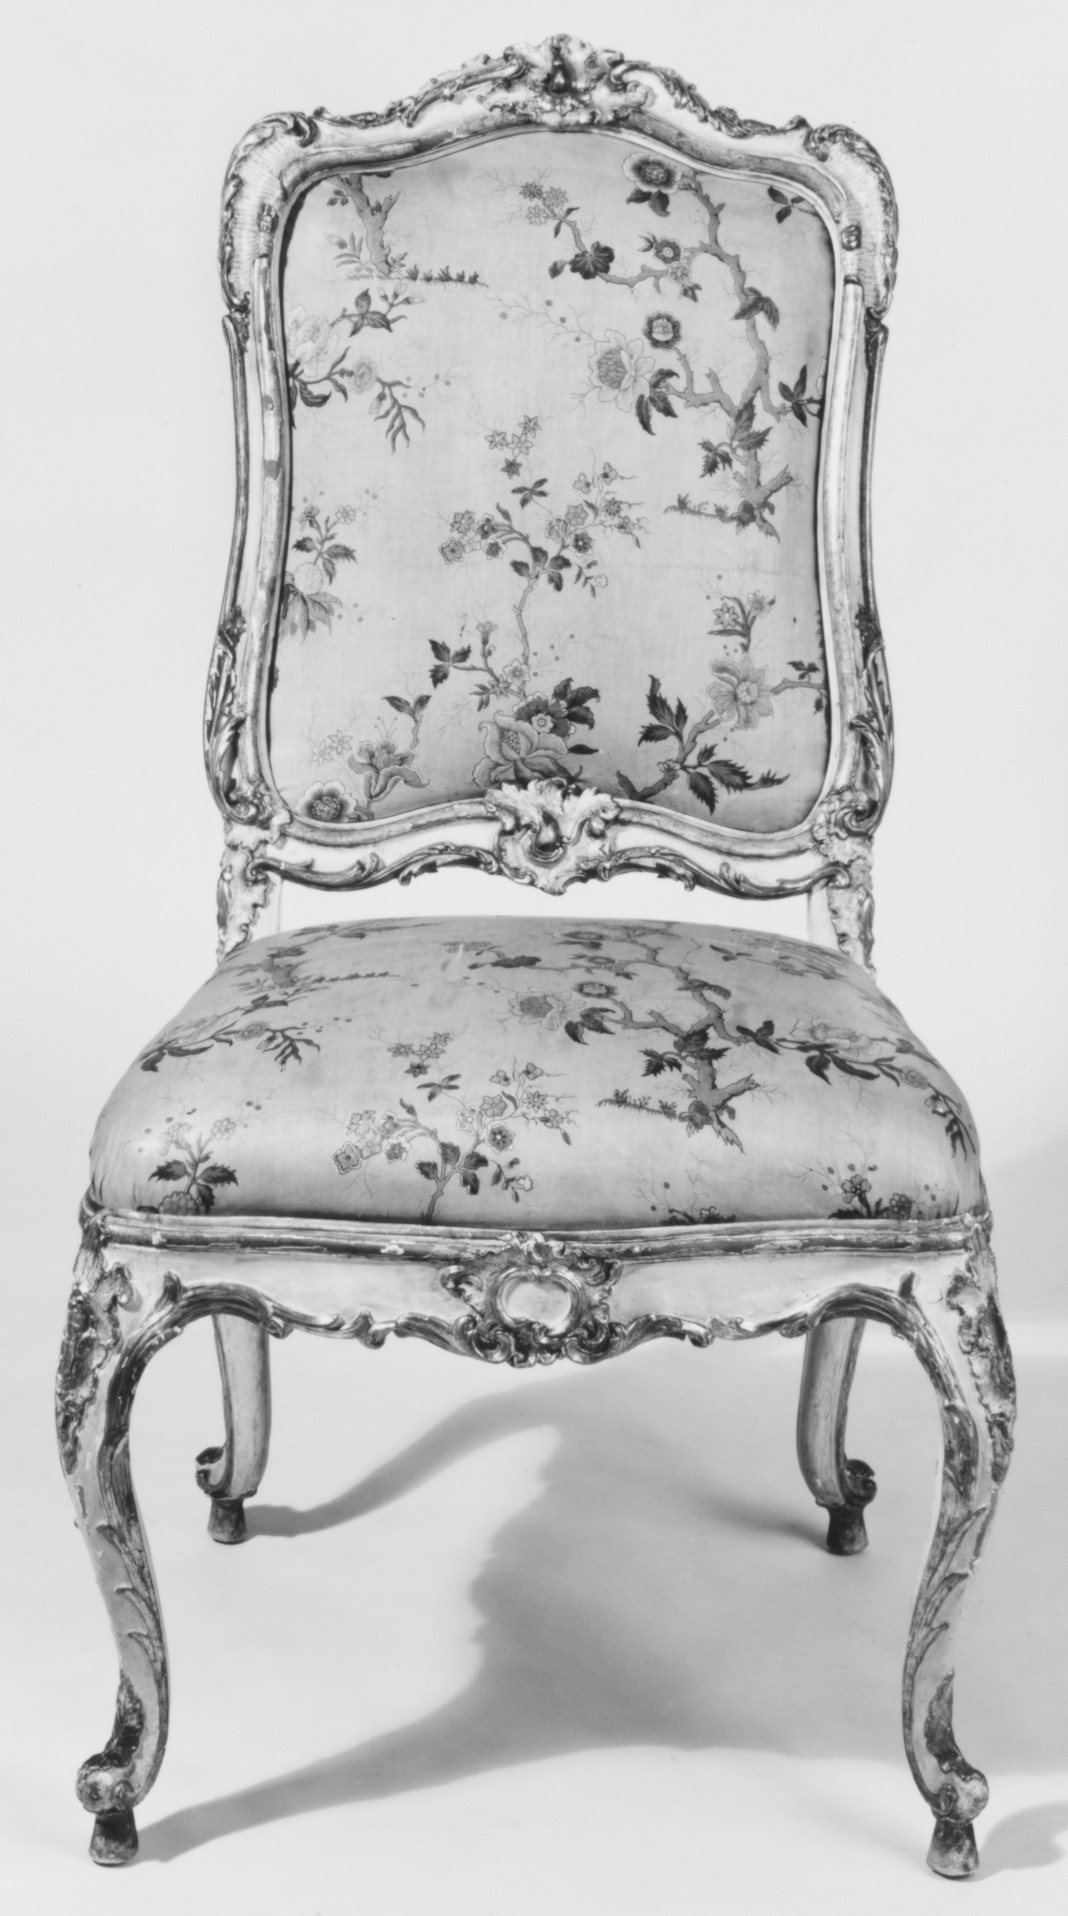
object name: side chair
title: Side chair (set of four)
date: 1750-1760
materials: wood, cotton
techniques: carving, gilding, painting, printing, silvered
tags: flowers